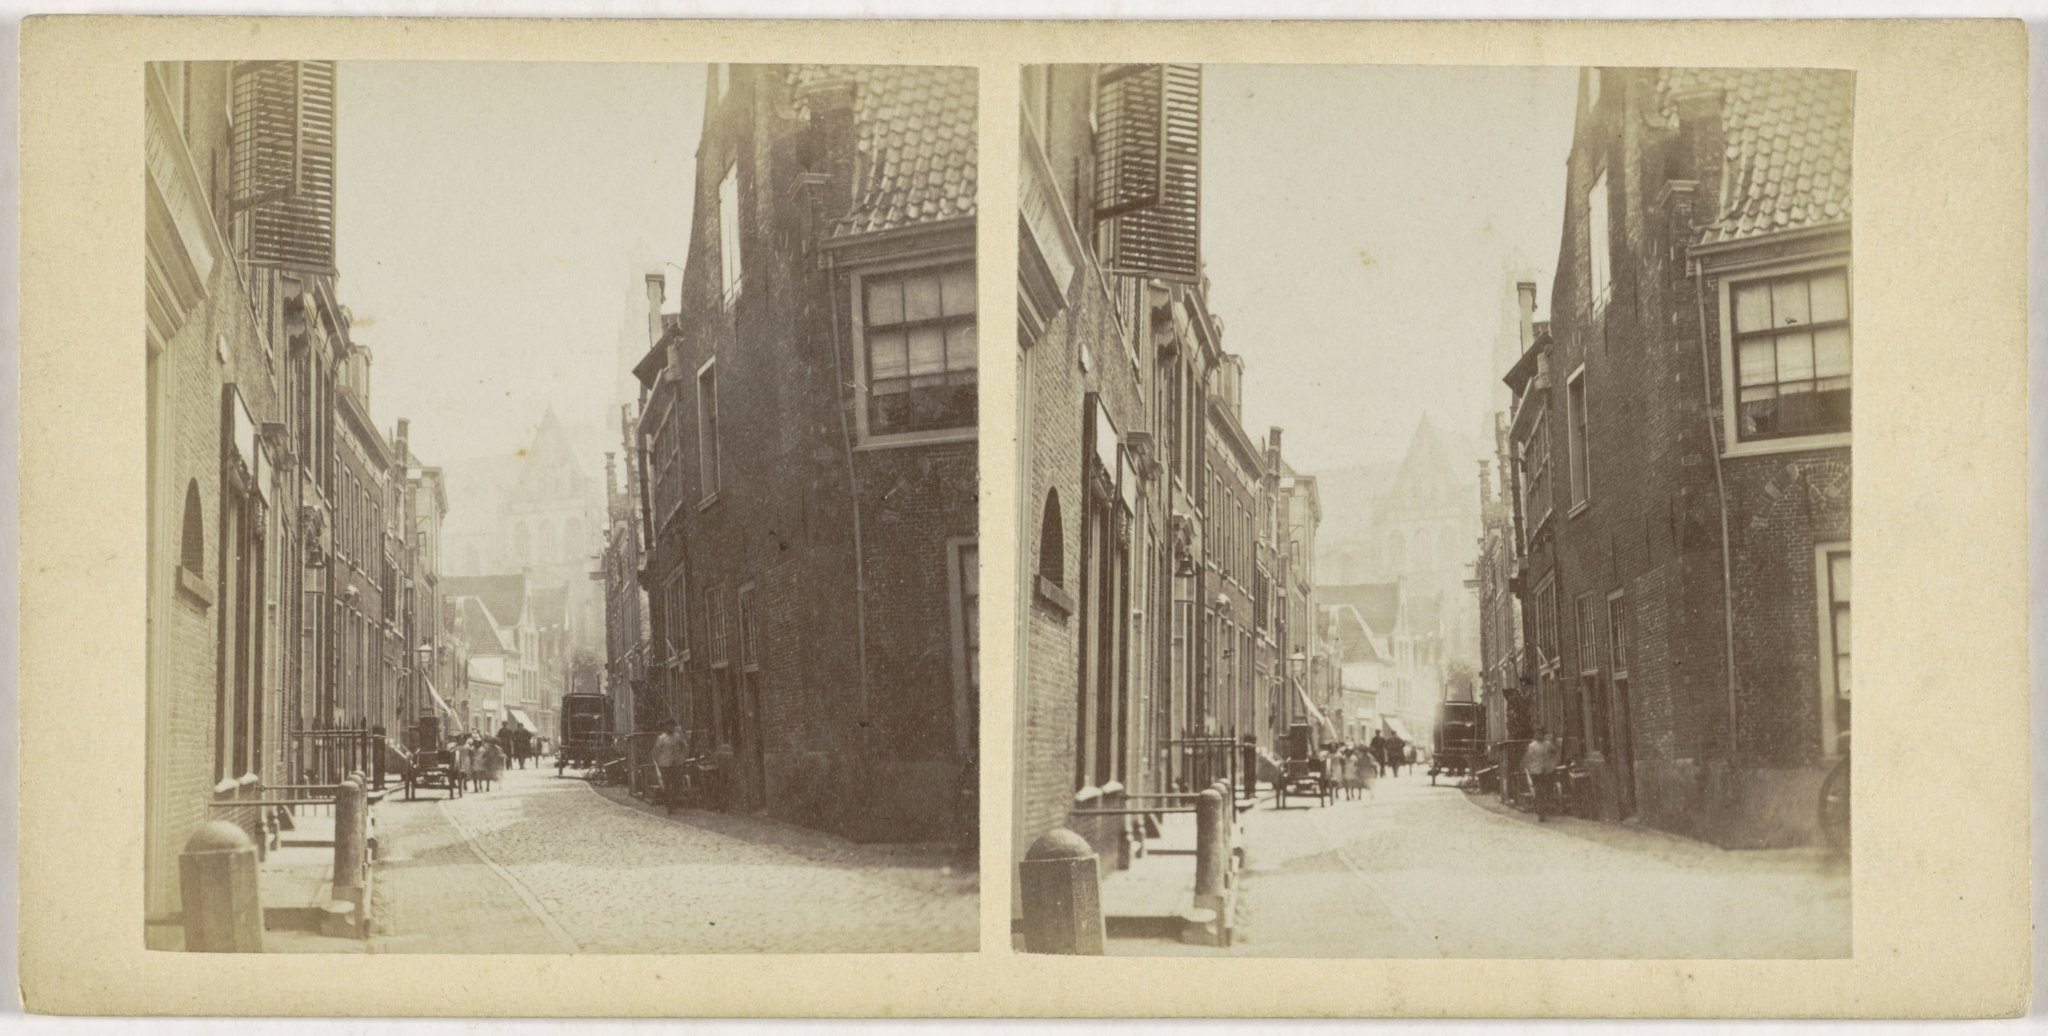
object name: stereograph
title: Gezicht op de Smedestraat in Haarlem met op de achtergrond de Grote of Sint-Bavokerk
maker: Anonymous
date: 1857-1863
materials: cardboard, paper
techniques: albumen print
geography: haarlem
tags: parts of church exterior and annexes, street, haarlem